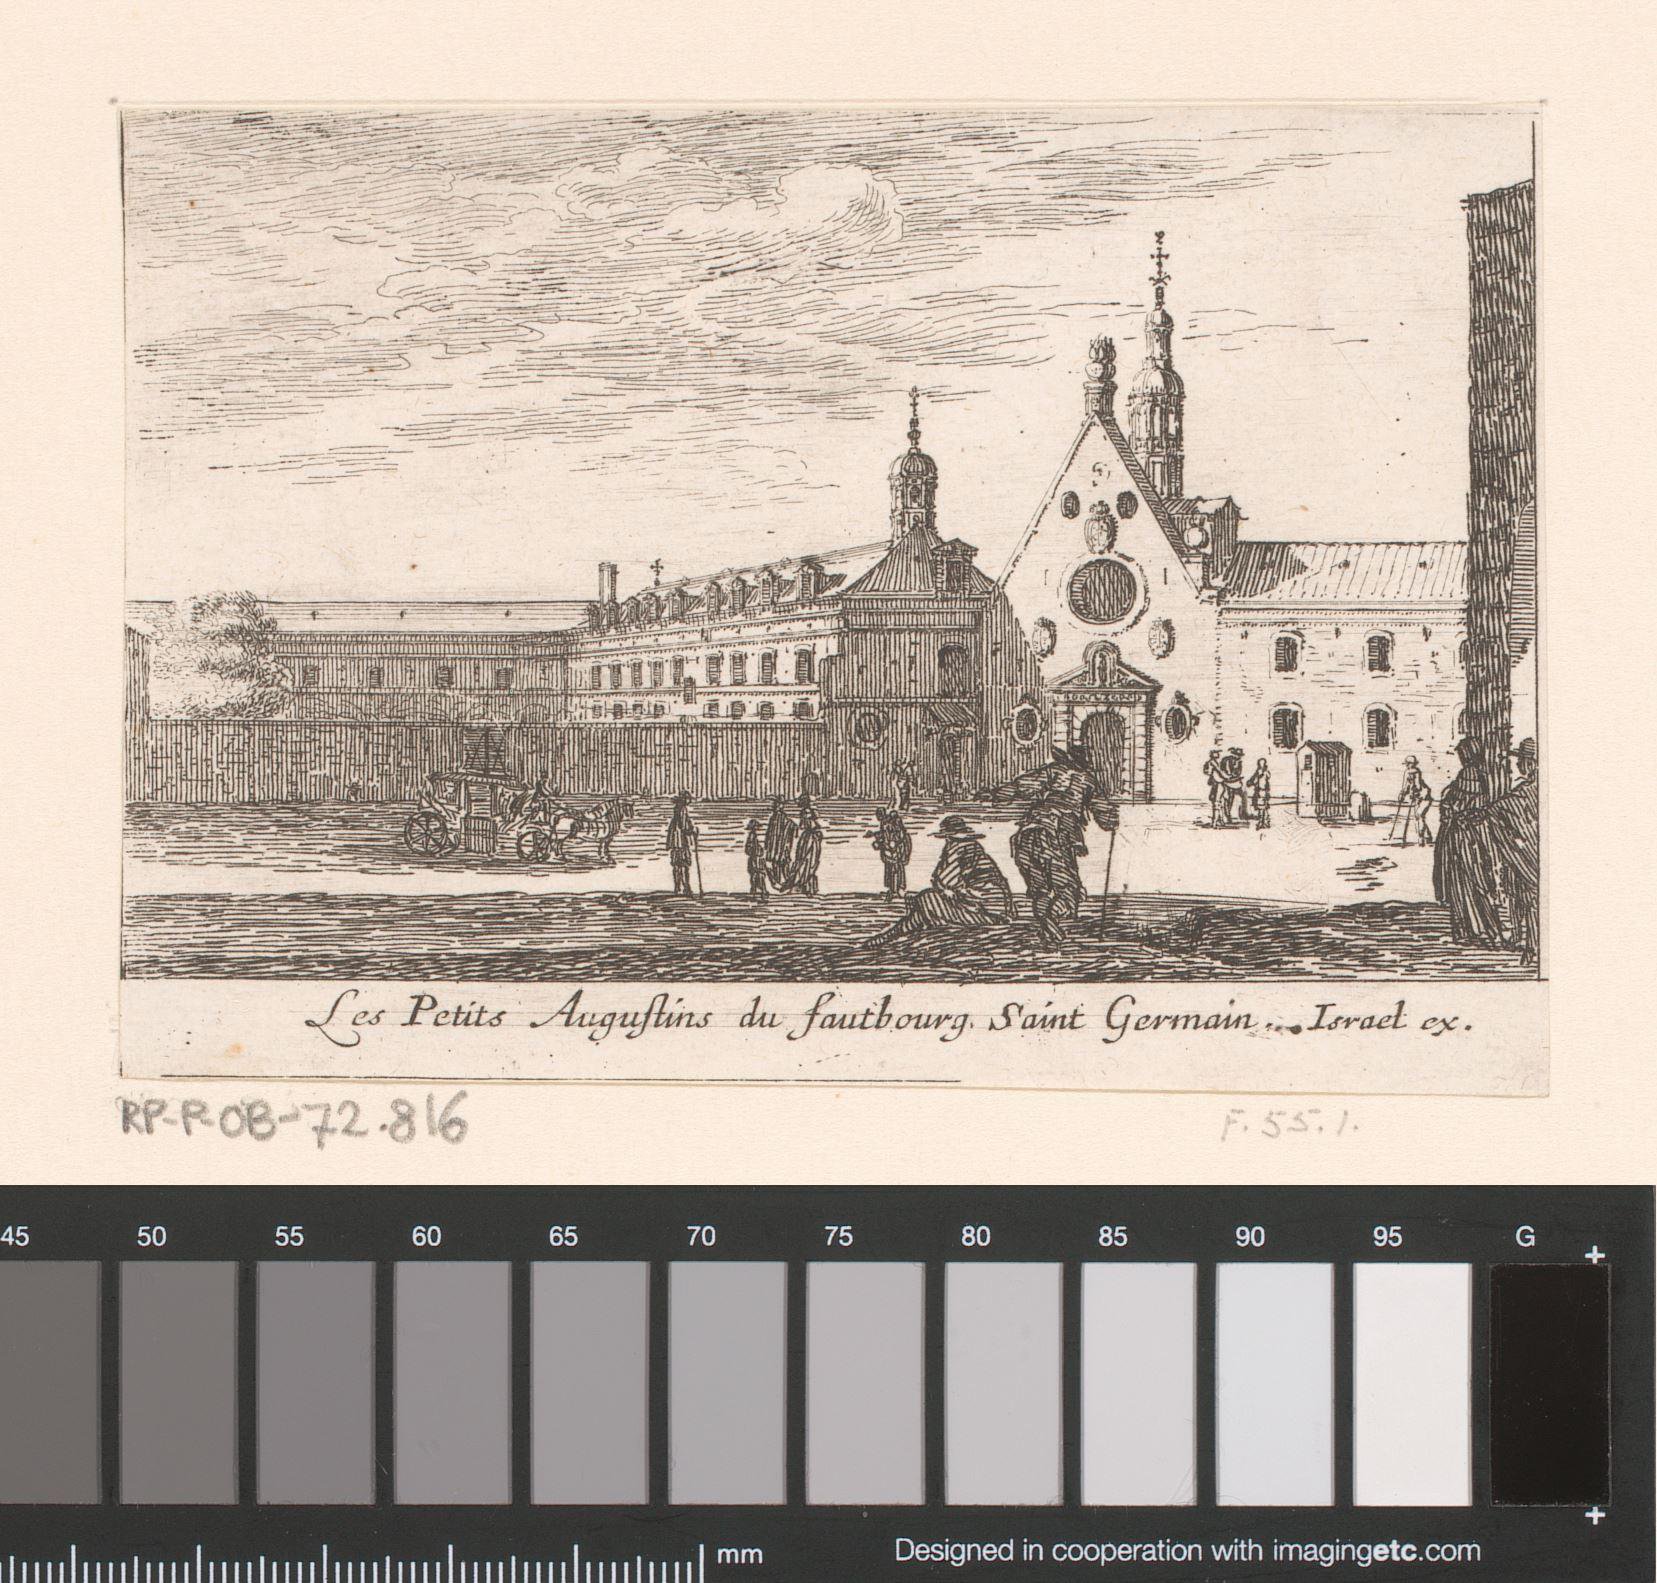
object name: print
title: Gezichten op Parijs en Frankrijk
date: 1631-1661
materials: paper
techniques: etching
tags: landscape with tower or castle (+ city(-scape) with figures, staffage)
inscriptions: collector's mark: Lugt 240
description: Prent maakt deel uit van een ongenummerde serie van zestien prenten.